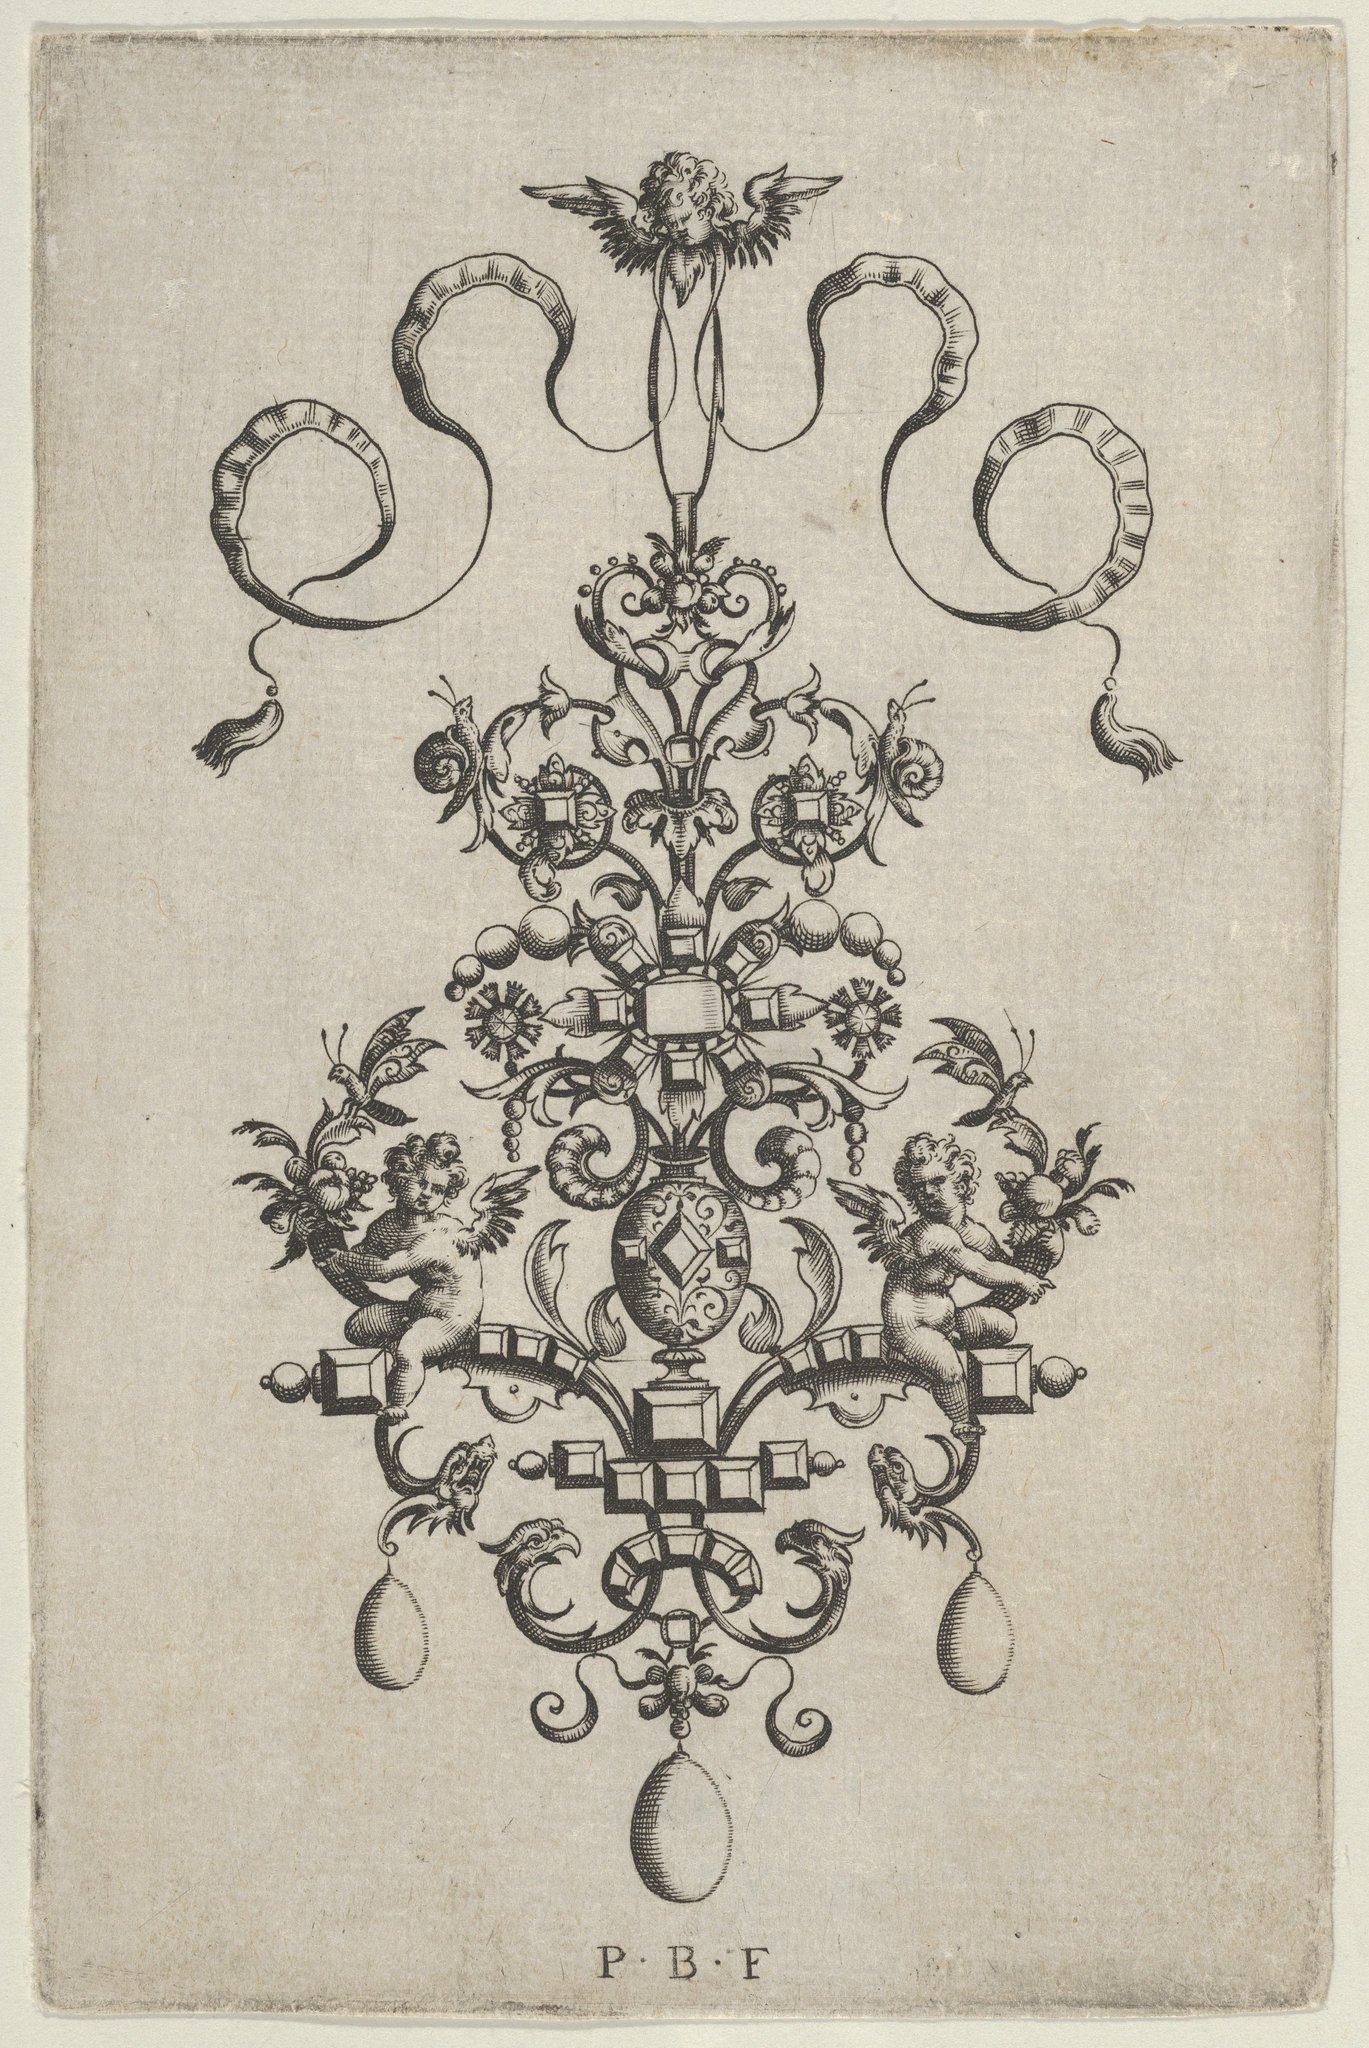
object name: print ornament architecture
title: Vertical Panel with Design for a Pendant, from Ars His Myronis Nobilis Effingitus Pagellulis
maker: paul birckenhultz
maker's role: artist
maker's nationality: german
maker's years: 1561-1639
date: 1600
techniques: engraving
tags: pendants